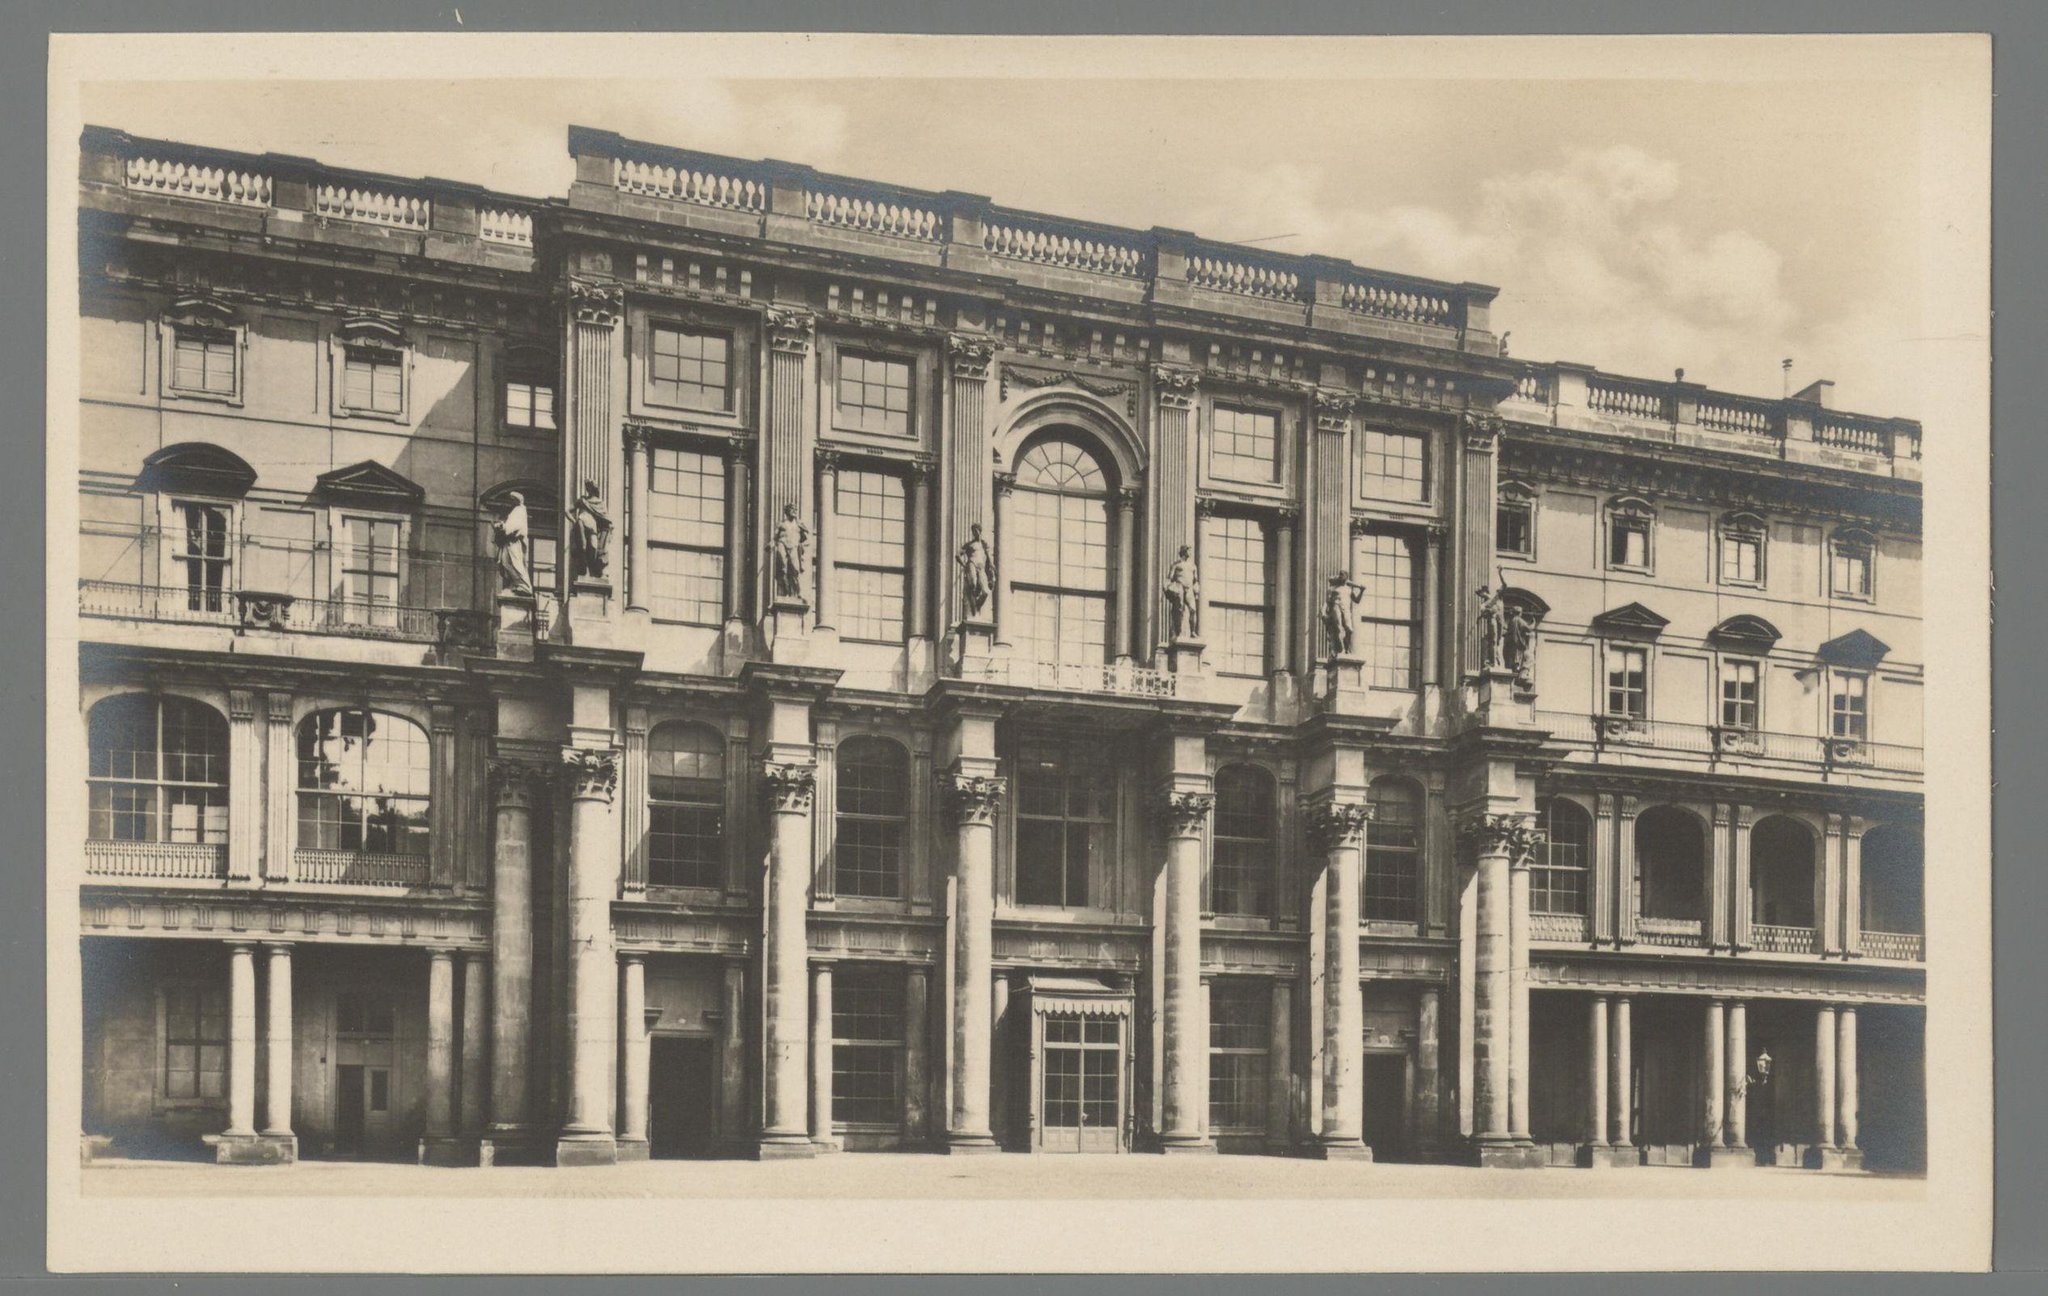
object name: ansichtkaart, prentbriefkaart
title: Berlin, Schloss. Östlicher Schlosshof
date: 1900-1930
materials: photographic support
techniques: photography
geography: berlin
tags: castle